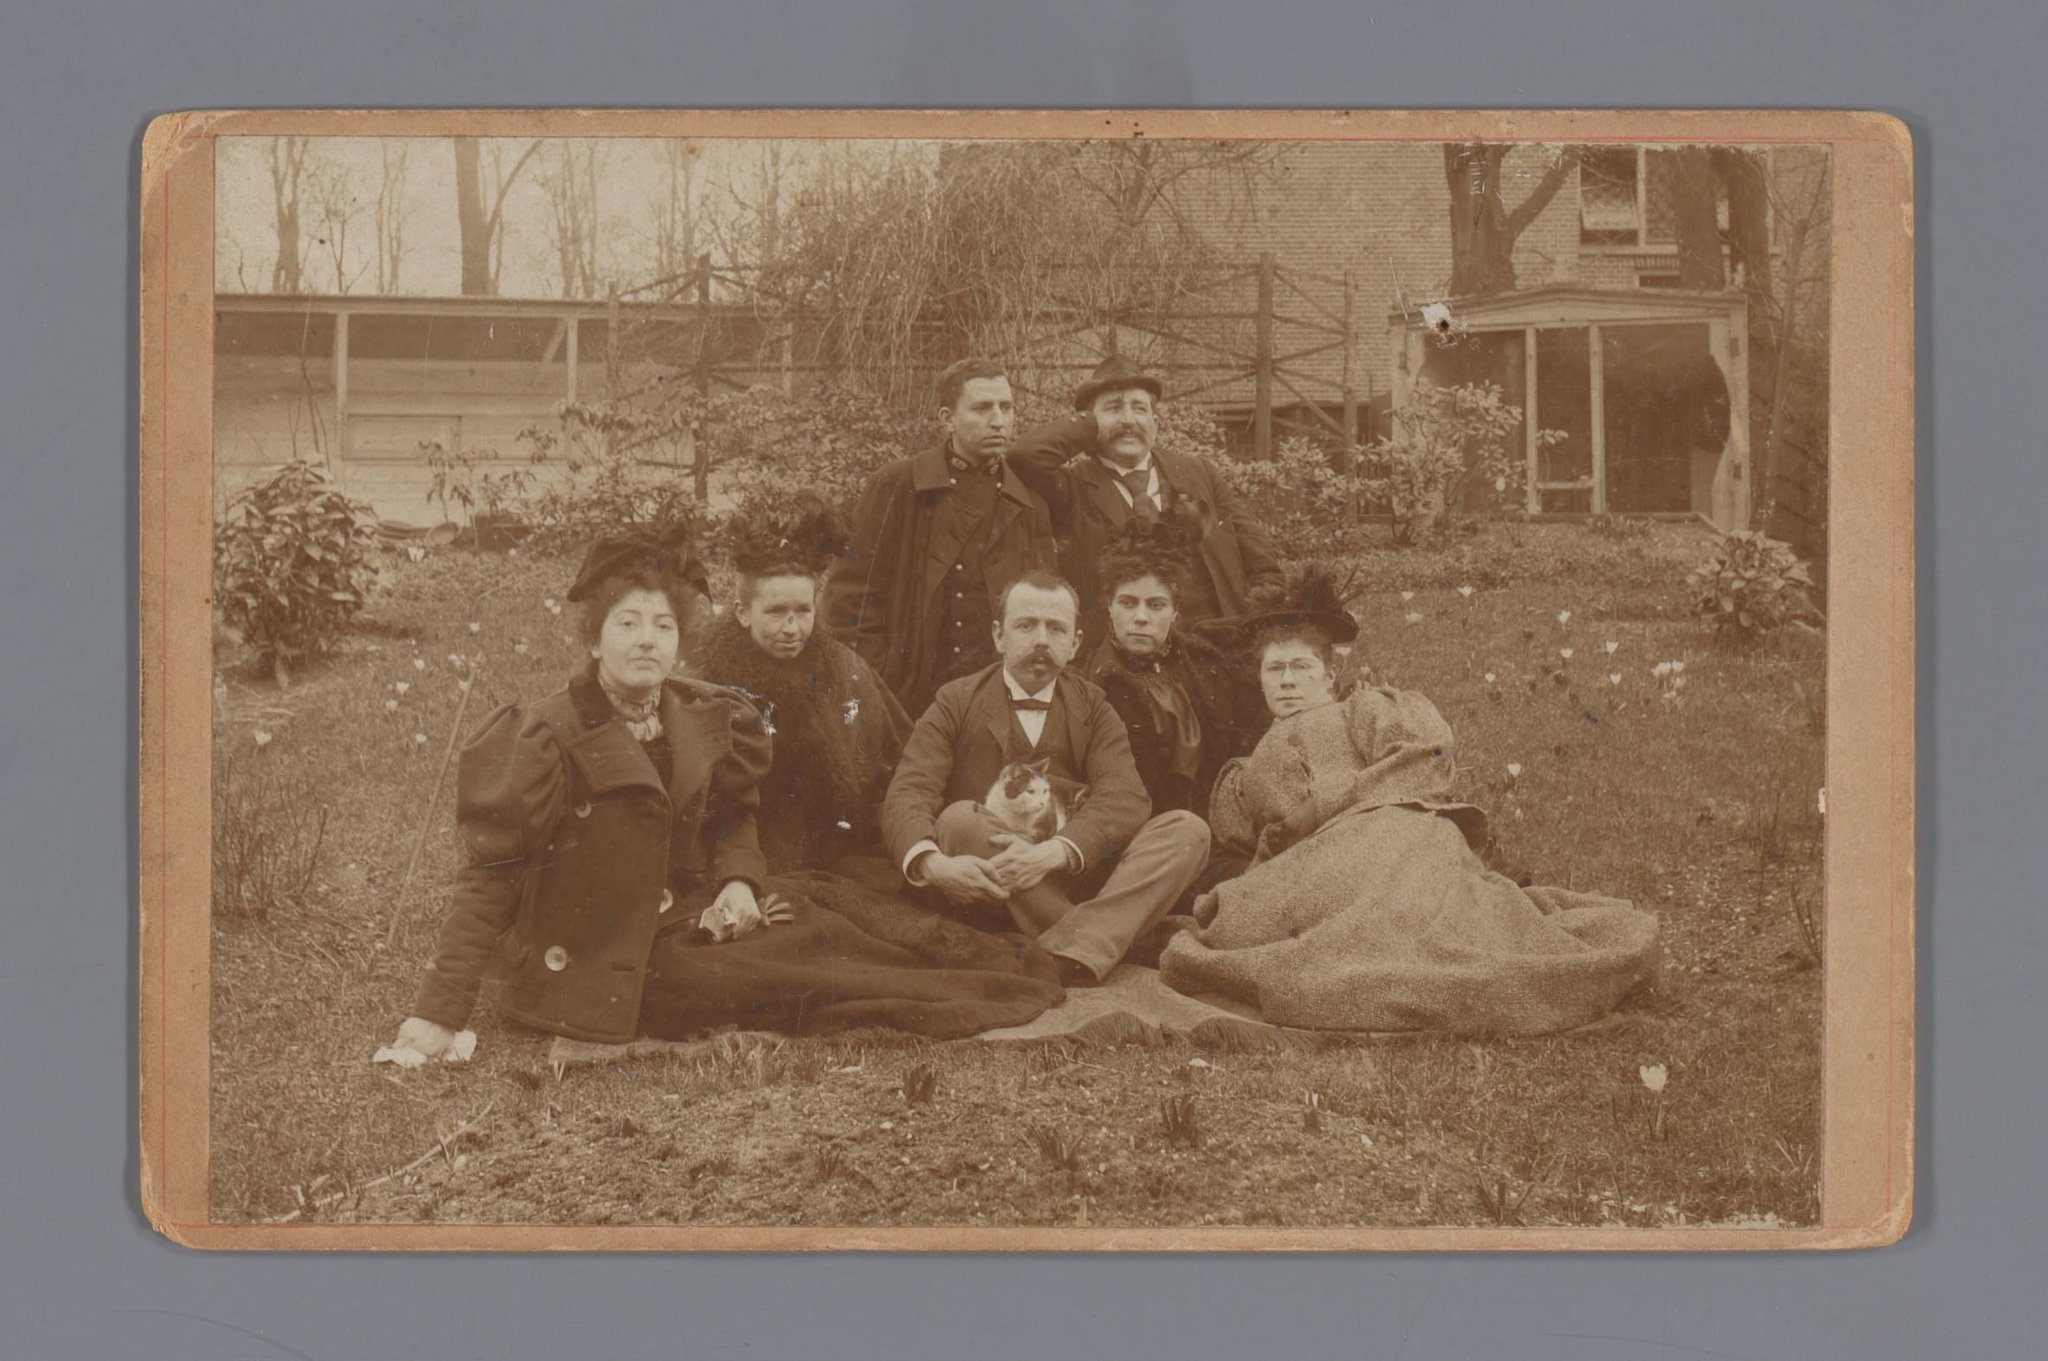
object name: cabinet photograph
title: Groepsportret van Willem Carel van der Kop en onbekende mensen met een kat in een achtertuin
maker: g. jan niekerk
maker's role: fotograaf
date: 1900-1910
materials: cardboard, photographic support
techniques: albumen print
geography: schoonhoven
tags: cat, backyard, anonymous historical persons portrayed in a group, in a group-portrait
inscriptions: name: ‘G. Jan Niekerk Albrecht Beijlinggracht Schoonhoven’